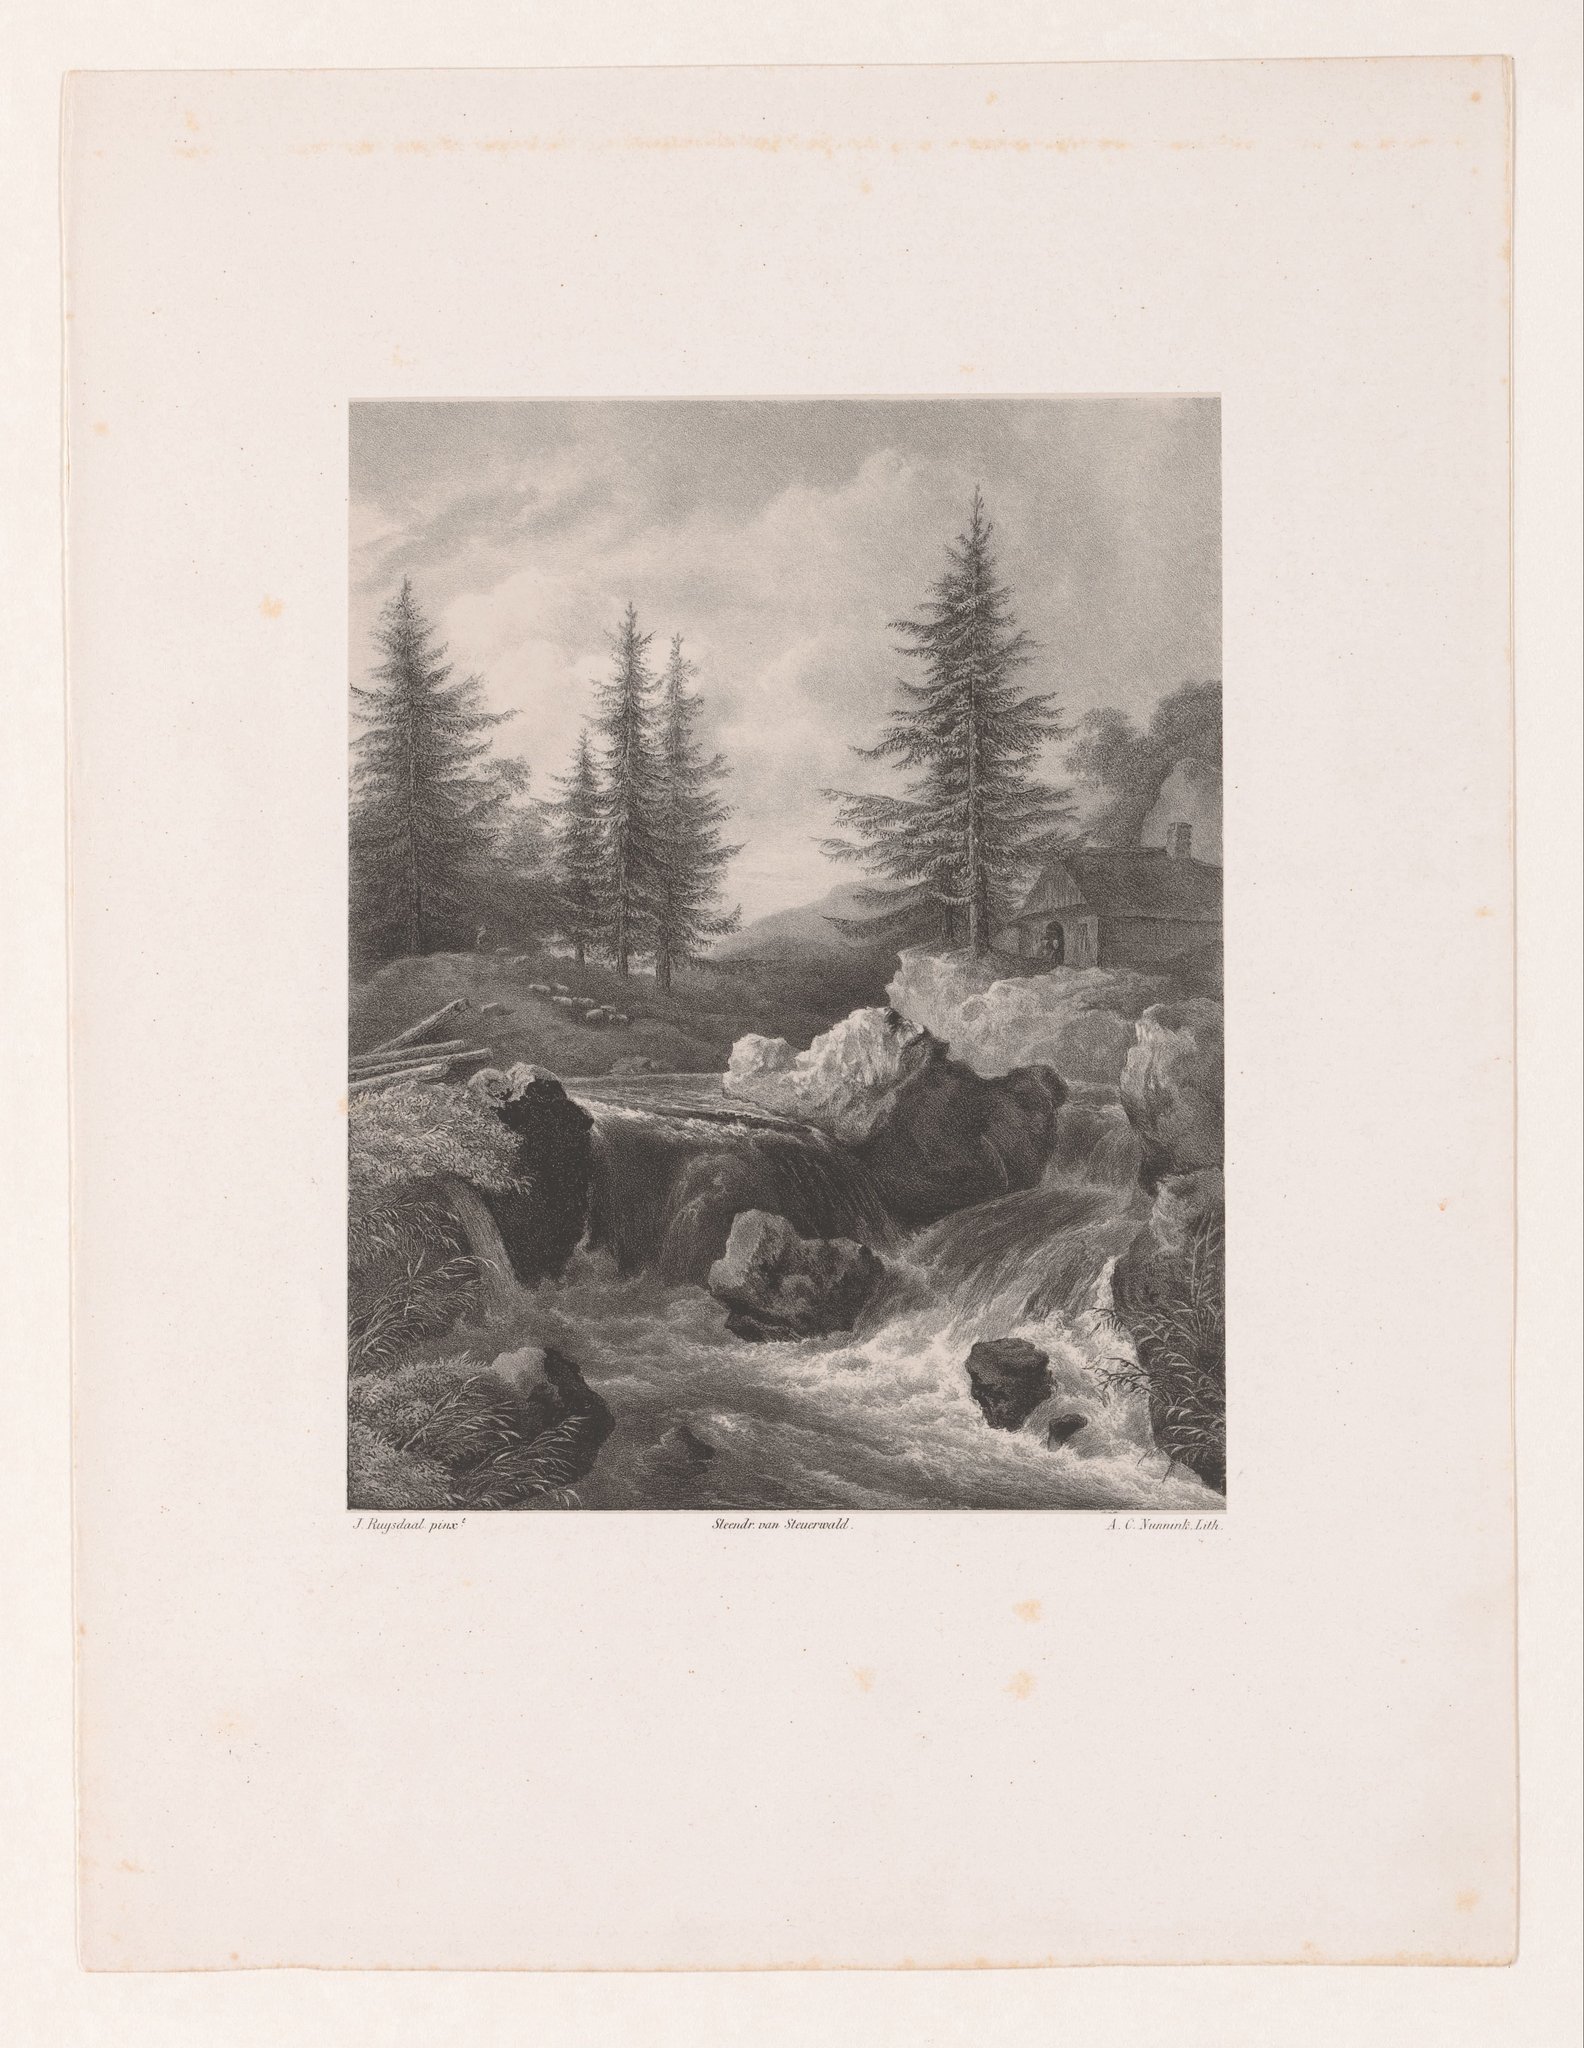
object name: print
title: Waterval bij huis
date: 1833-1869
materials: paper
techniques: lithograph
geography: the hague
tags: waterfall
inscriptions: collector's mark: Lugt 2233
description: Een landschap met dennenbomen en een waterval met rechts een huis.